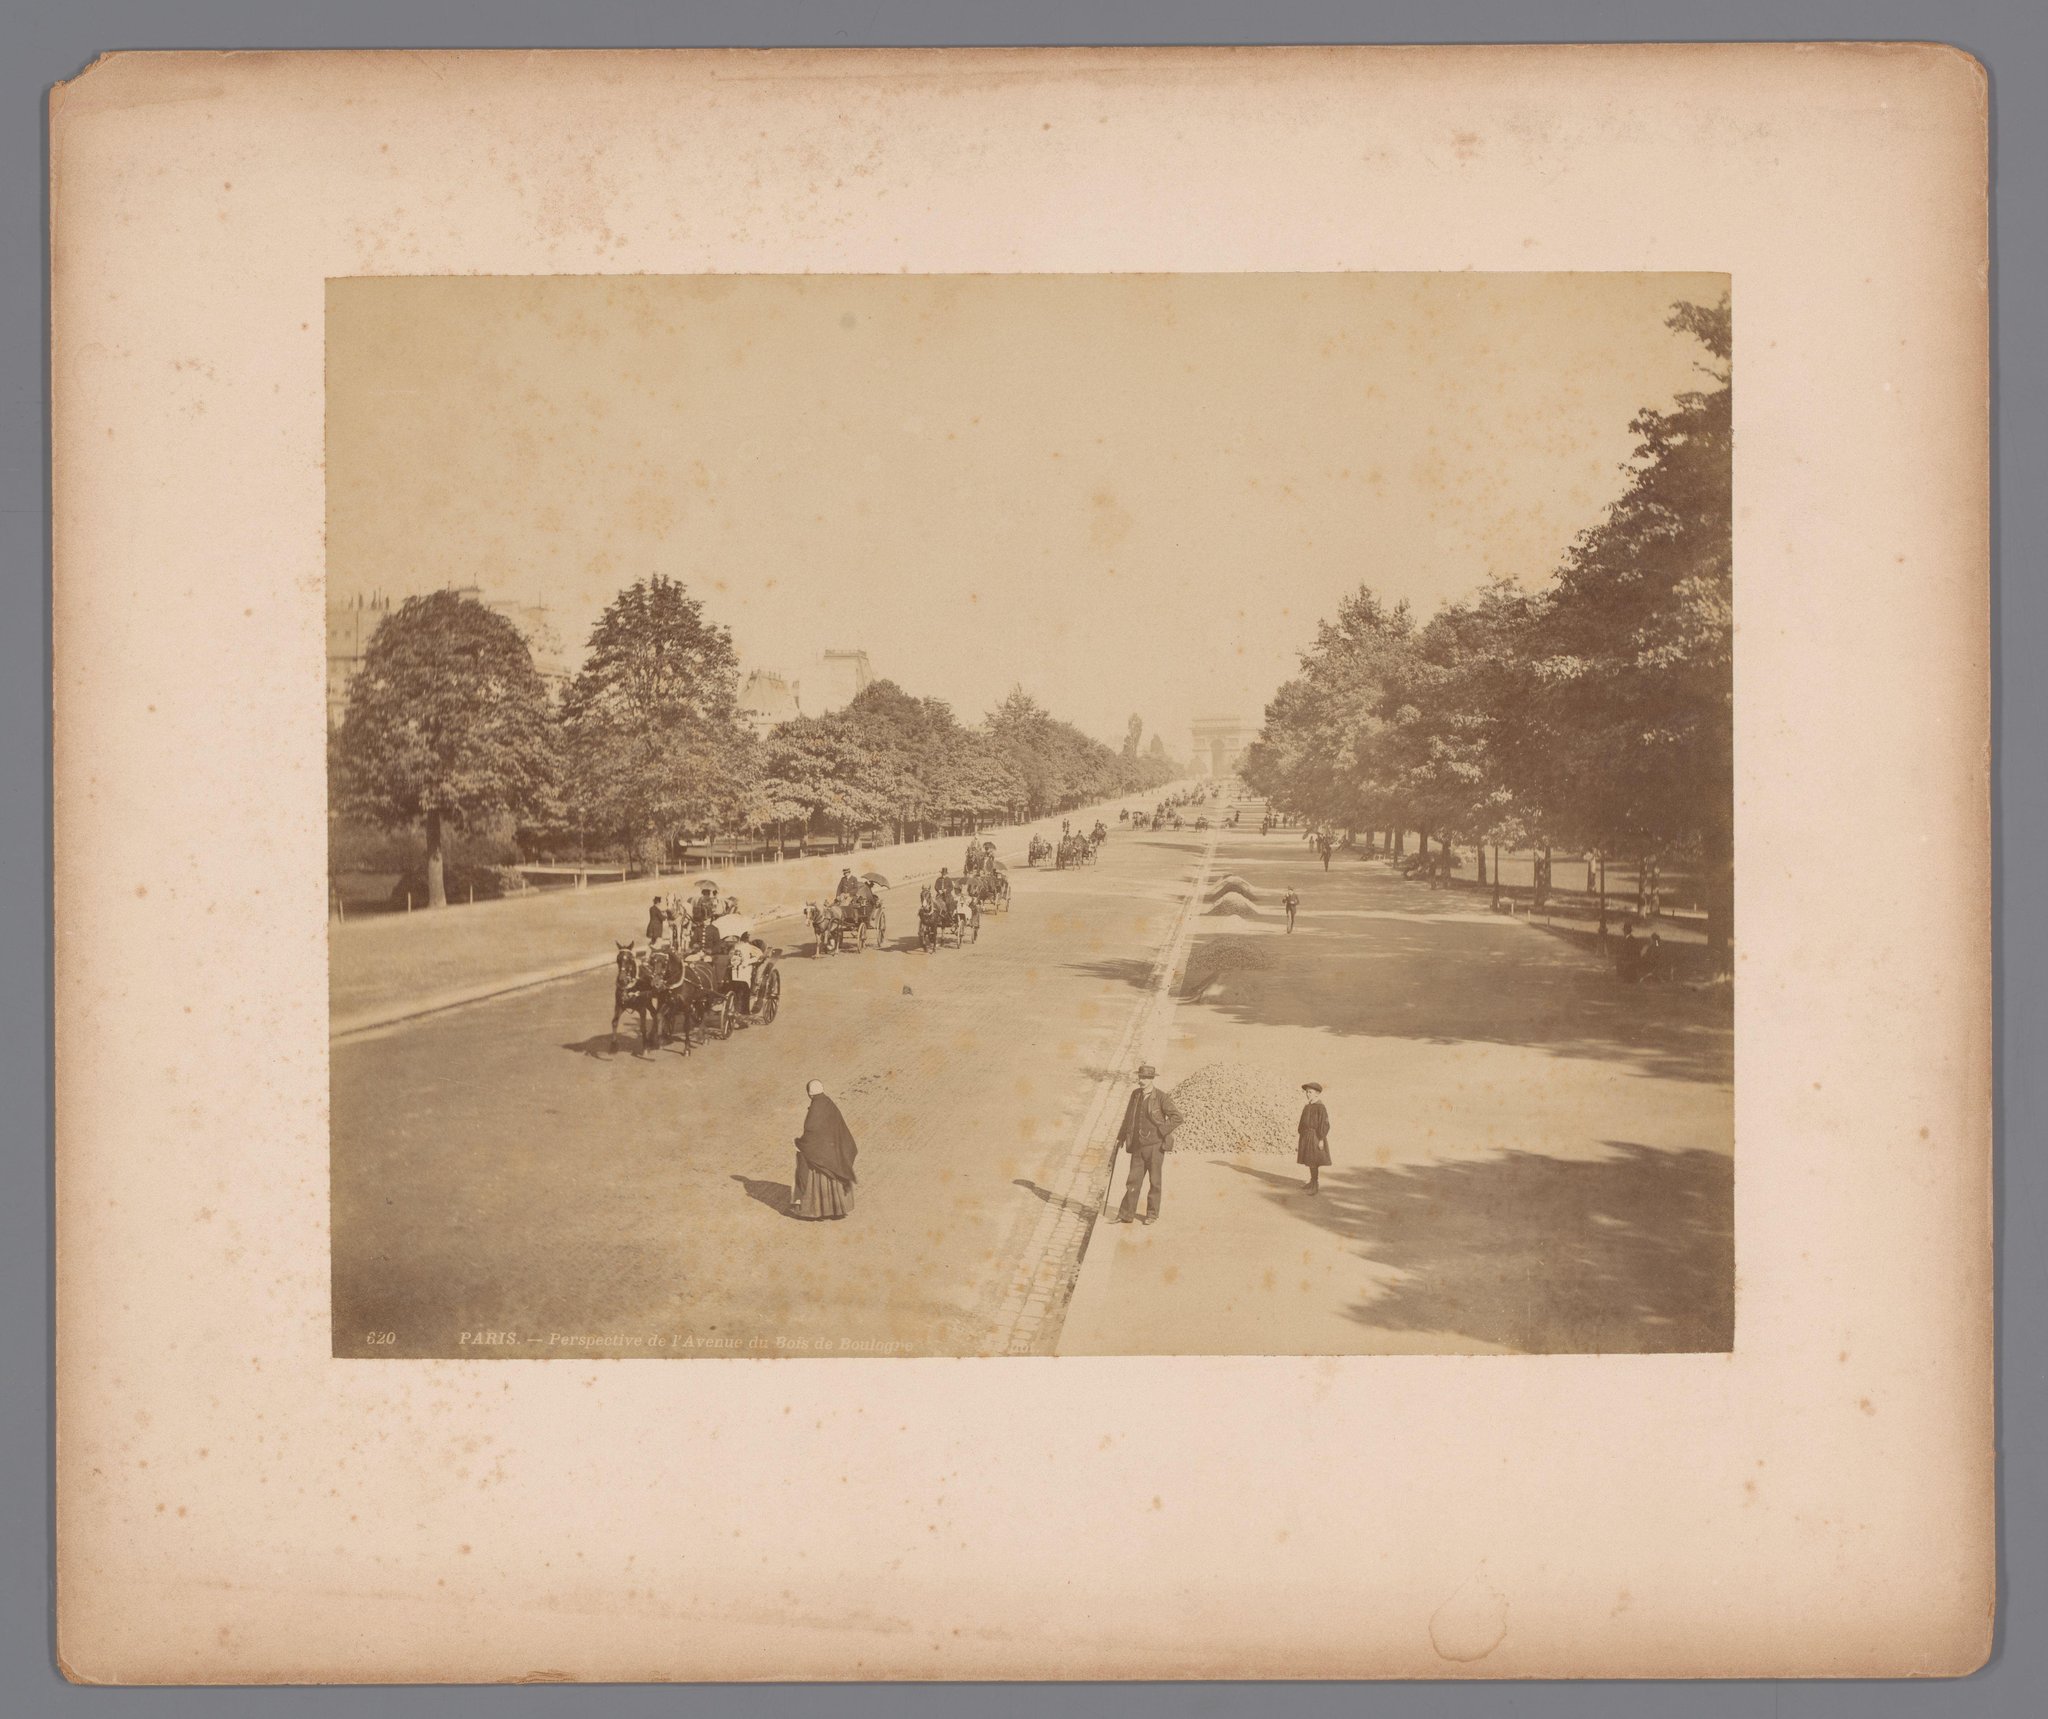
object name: photograph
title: 'Perspective de l'Avenue du Bois de Boulogne', Parijs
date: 1880-1900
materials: cardboard, paper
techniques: albumen print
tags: paris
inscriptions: inscription: ‘620 PARIS. - Perspective de l'Avenue du Bois de Boulogne’